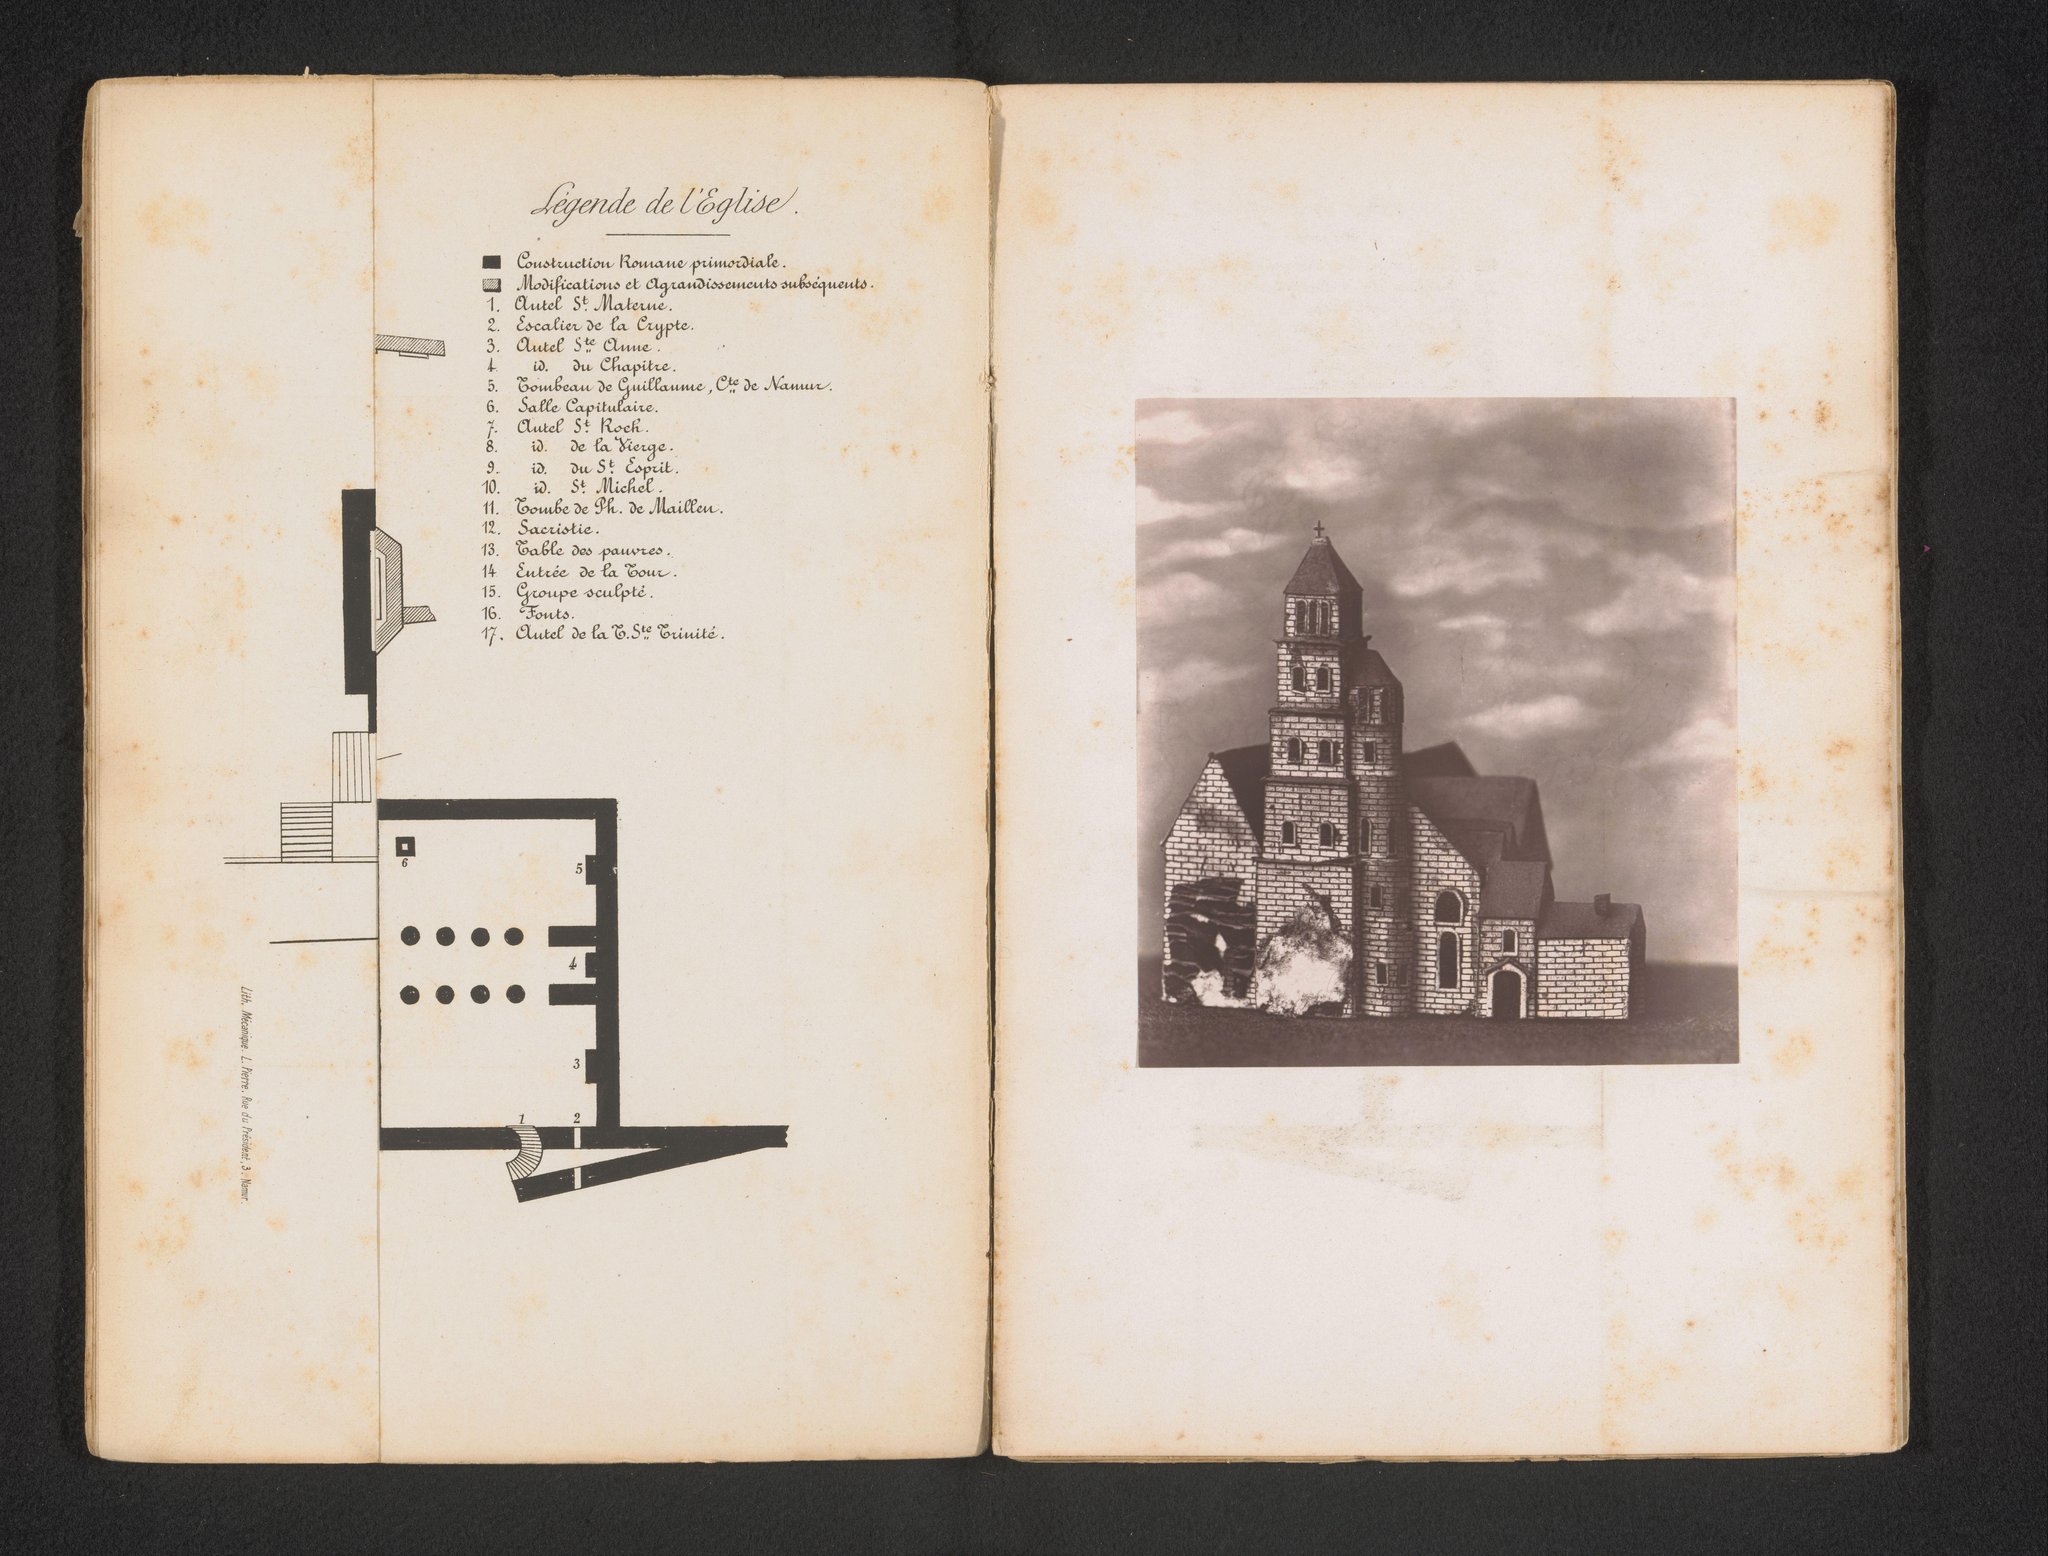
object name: photograph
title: Maquette van een kerk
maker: Anonymous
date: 1870-1875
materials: paper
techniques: carbon print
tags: model ~ architecture